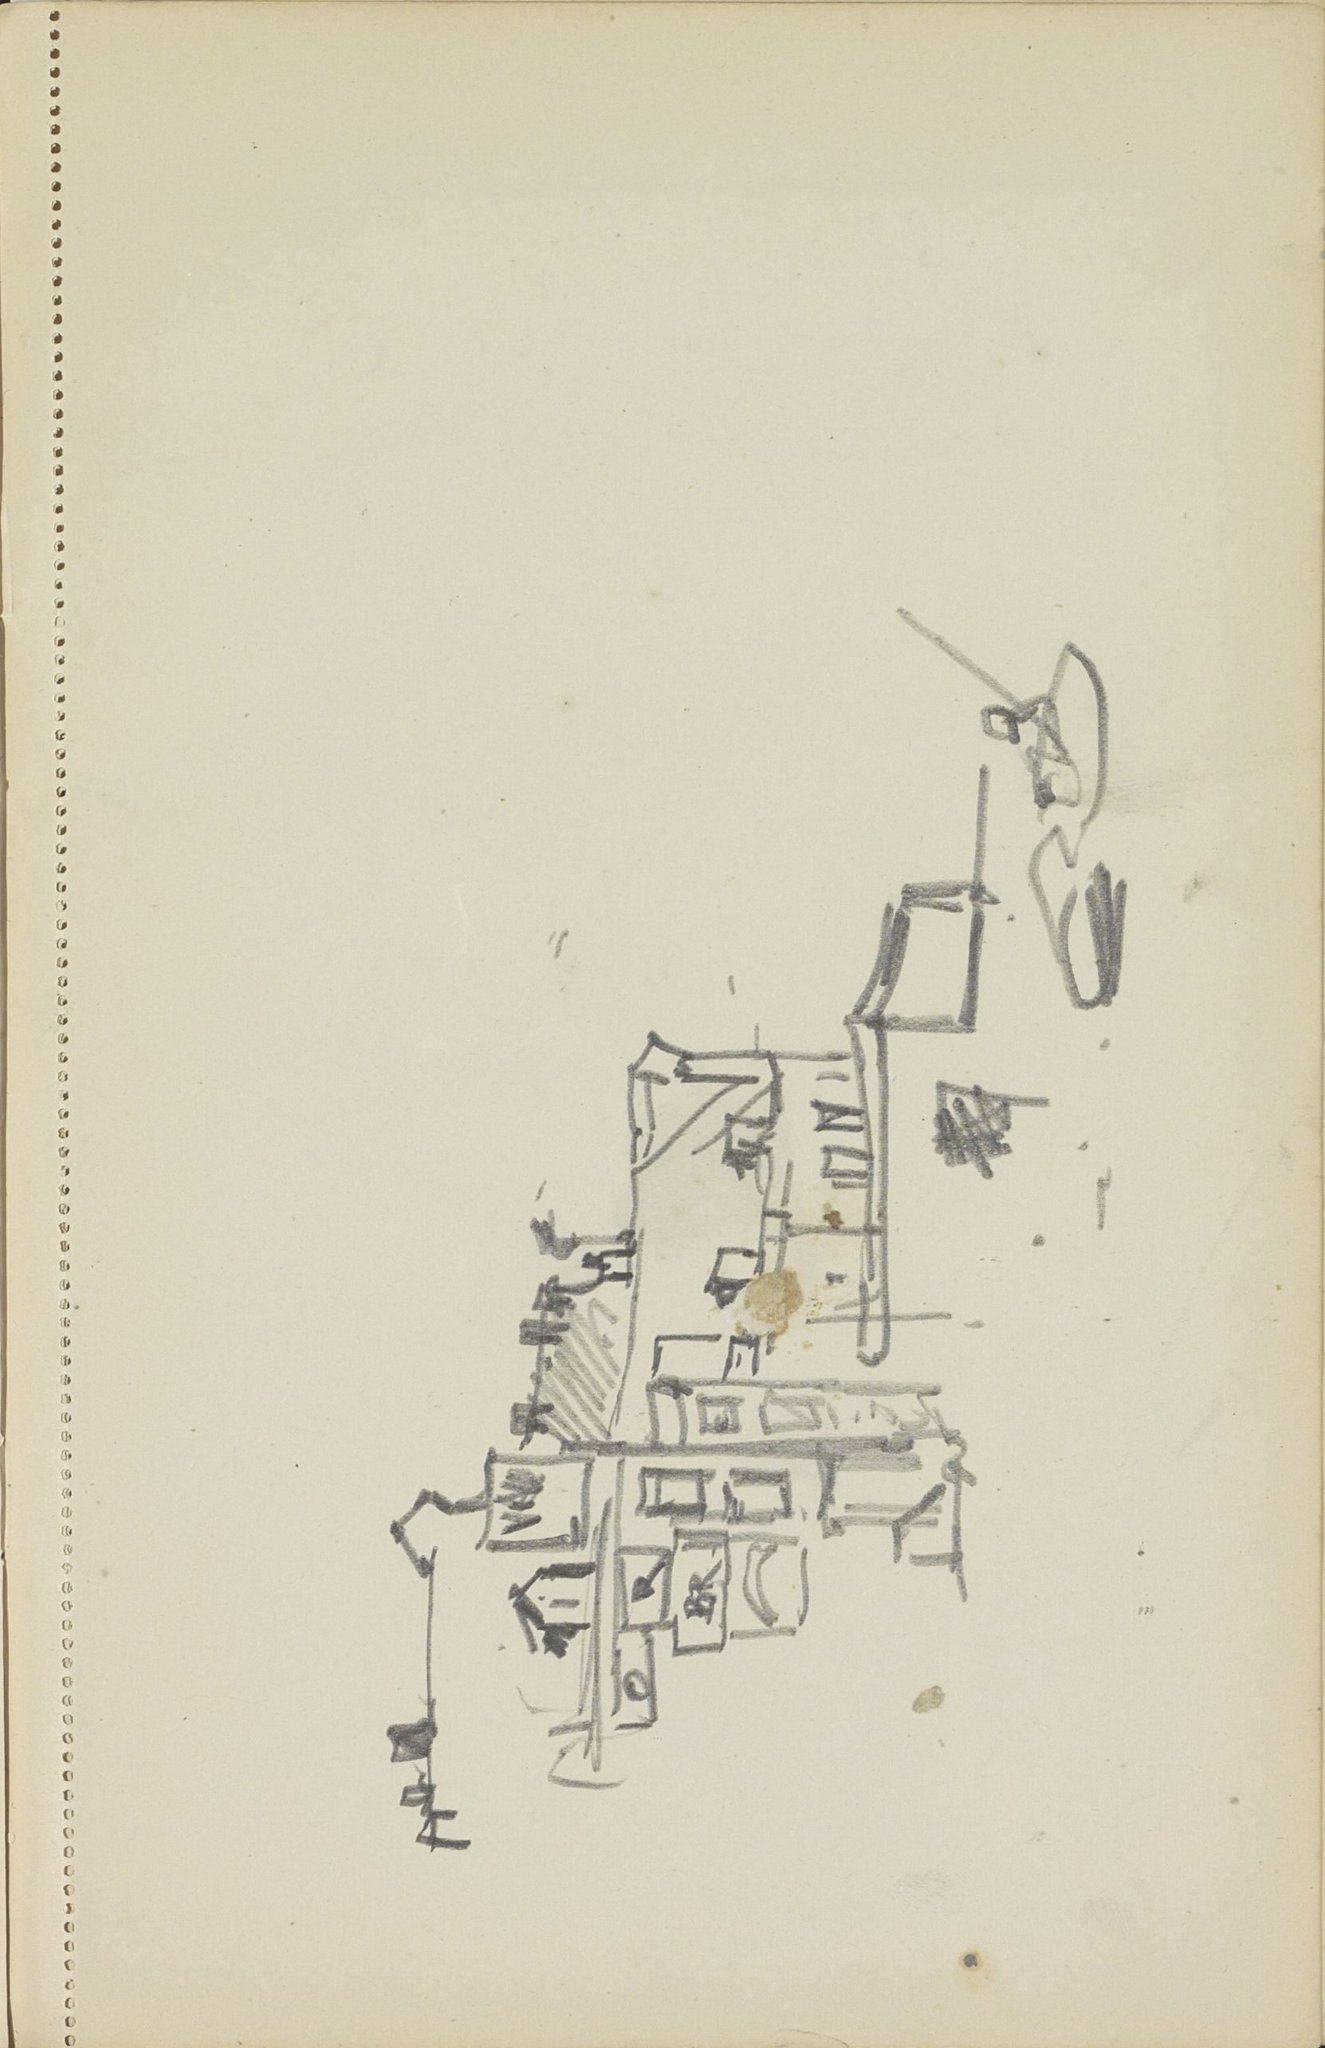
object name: sketchbook leaf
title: Huizen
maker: cornelis vreedenburgh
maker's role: draughtsman, print maker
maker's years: 1880-1946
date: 1890-1946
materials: paper, pencil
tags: housing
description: Blad 32 recto uit een schetsboek met 56 bladen.